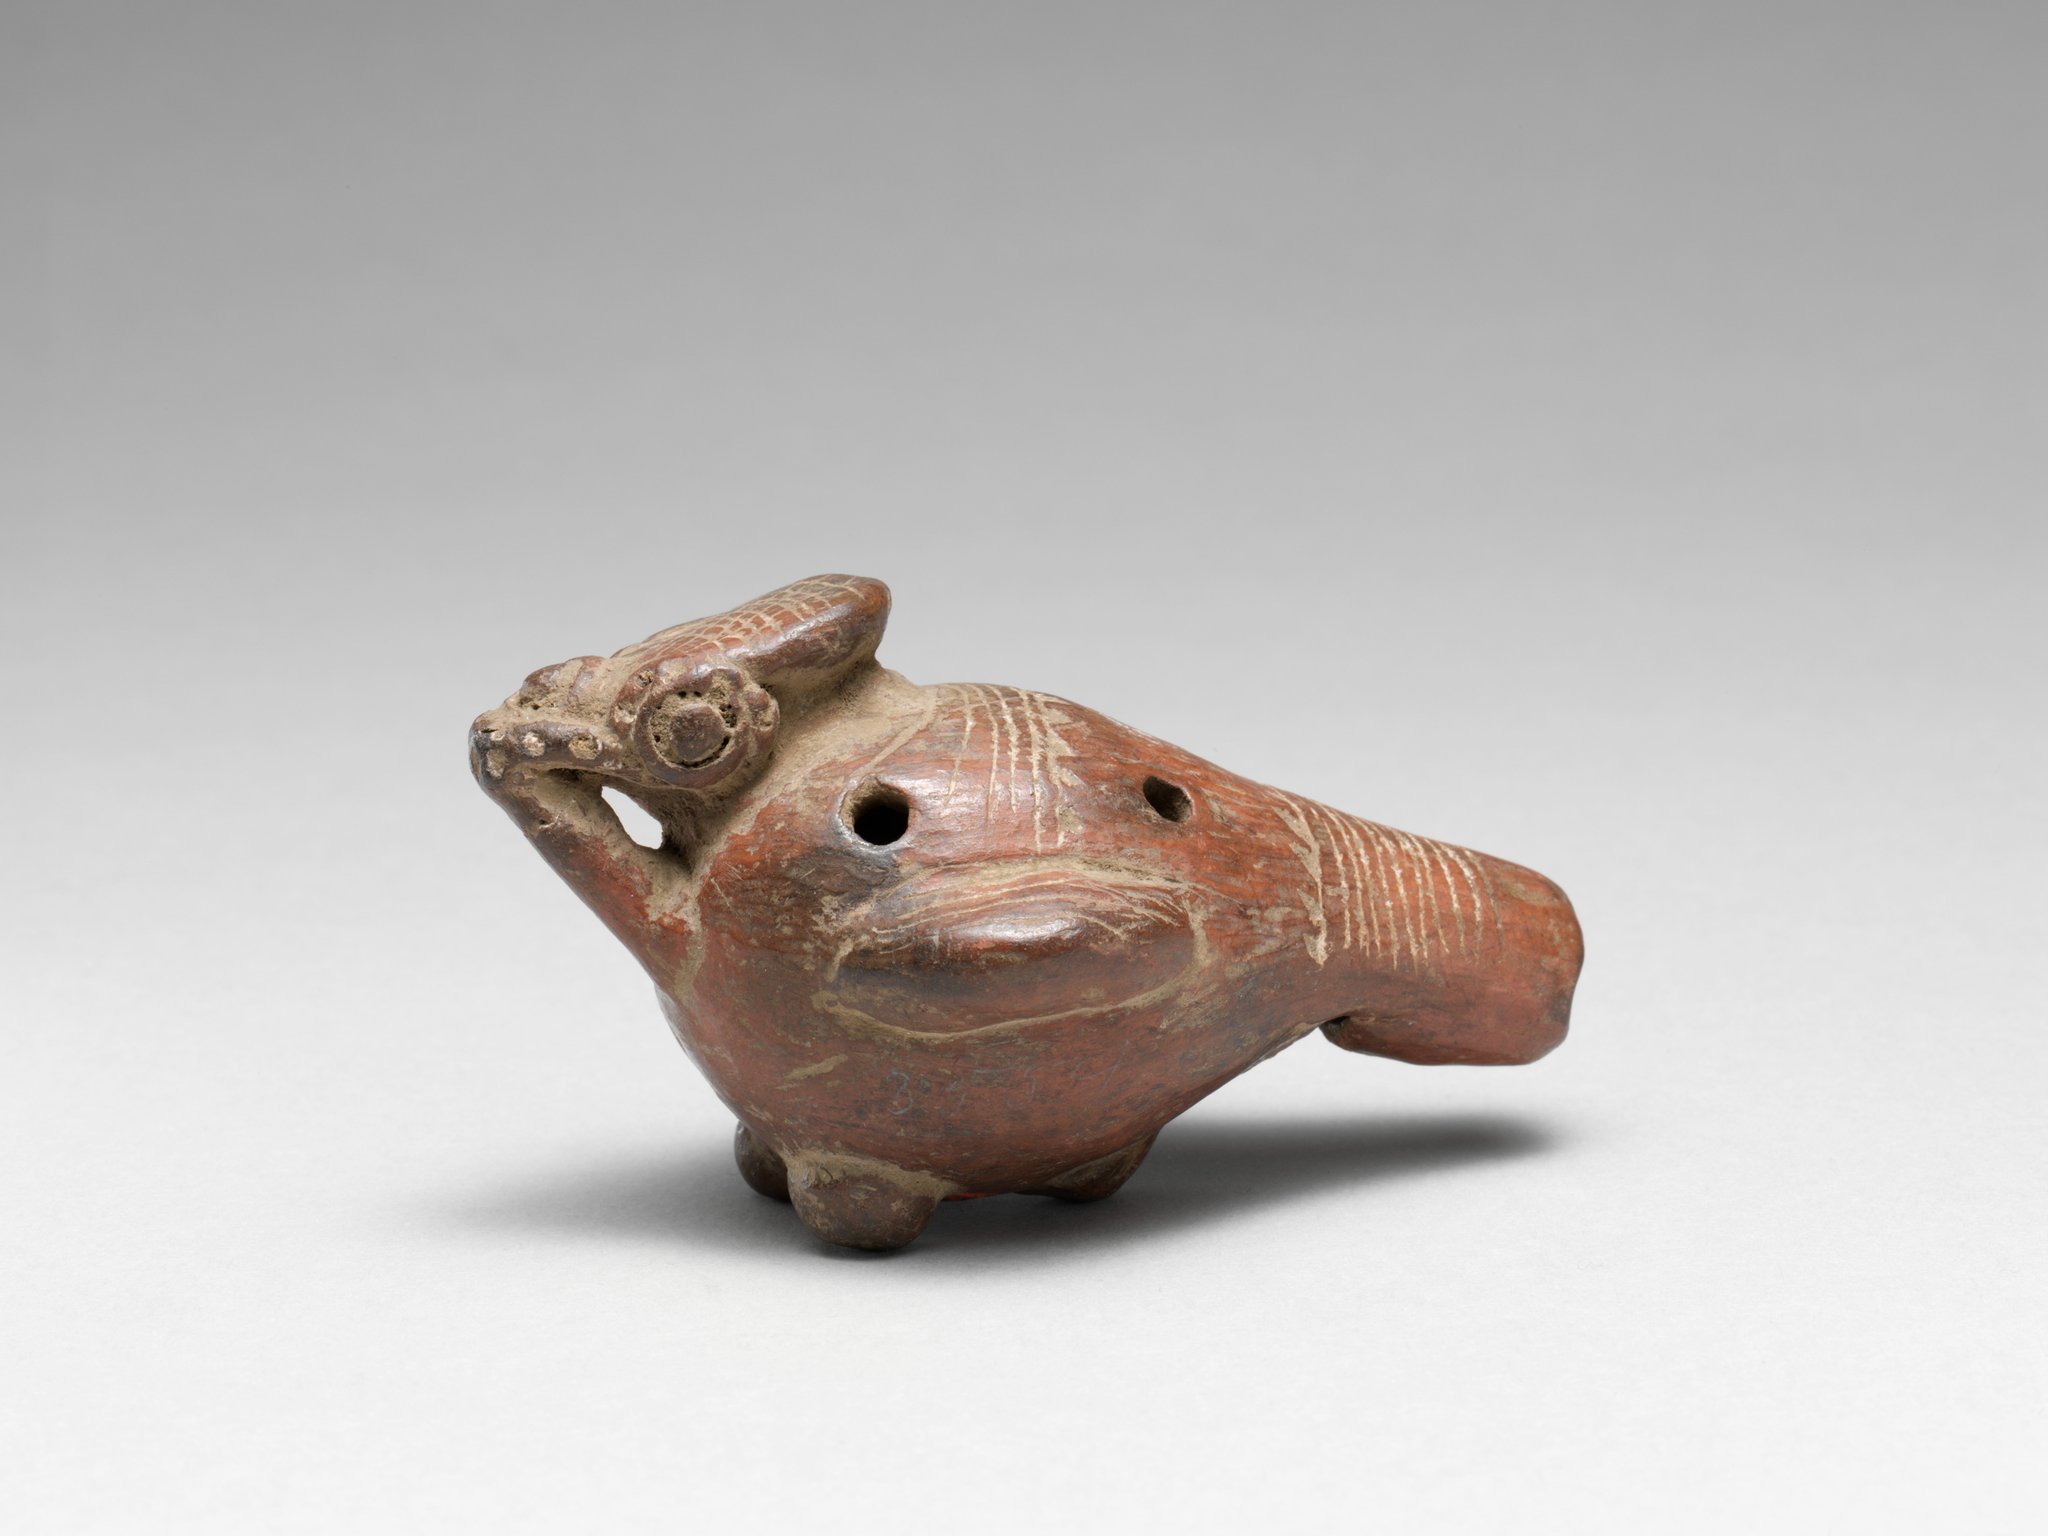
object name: pottery whistle and rattle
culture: costa rican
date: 800-1525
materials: clay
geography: costa rica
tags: birds